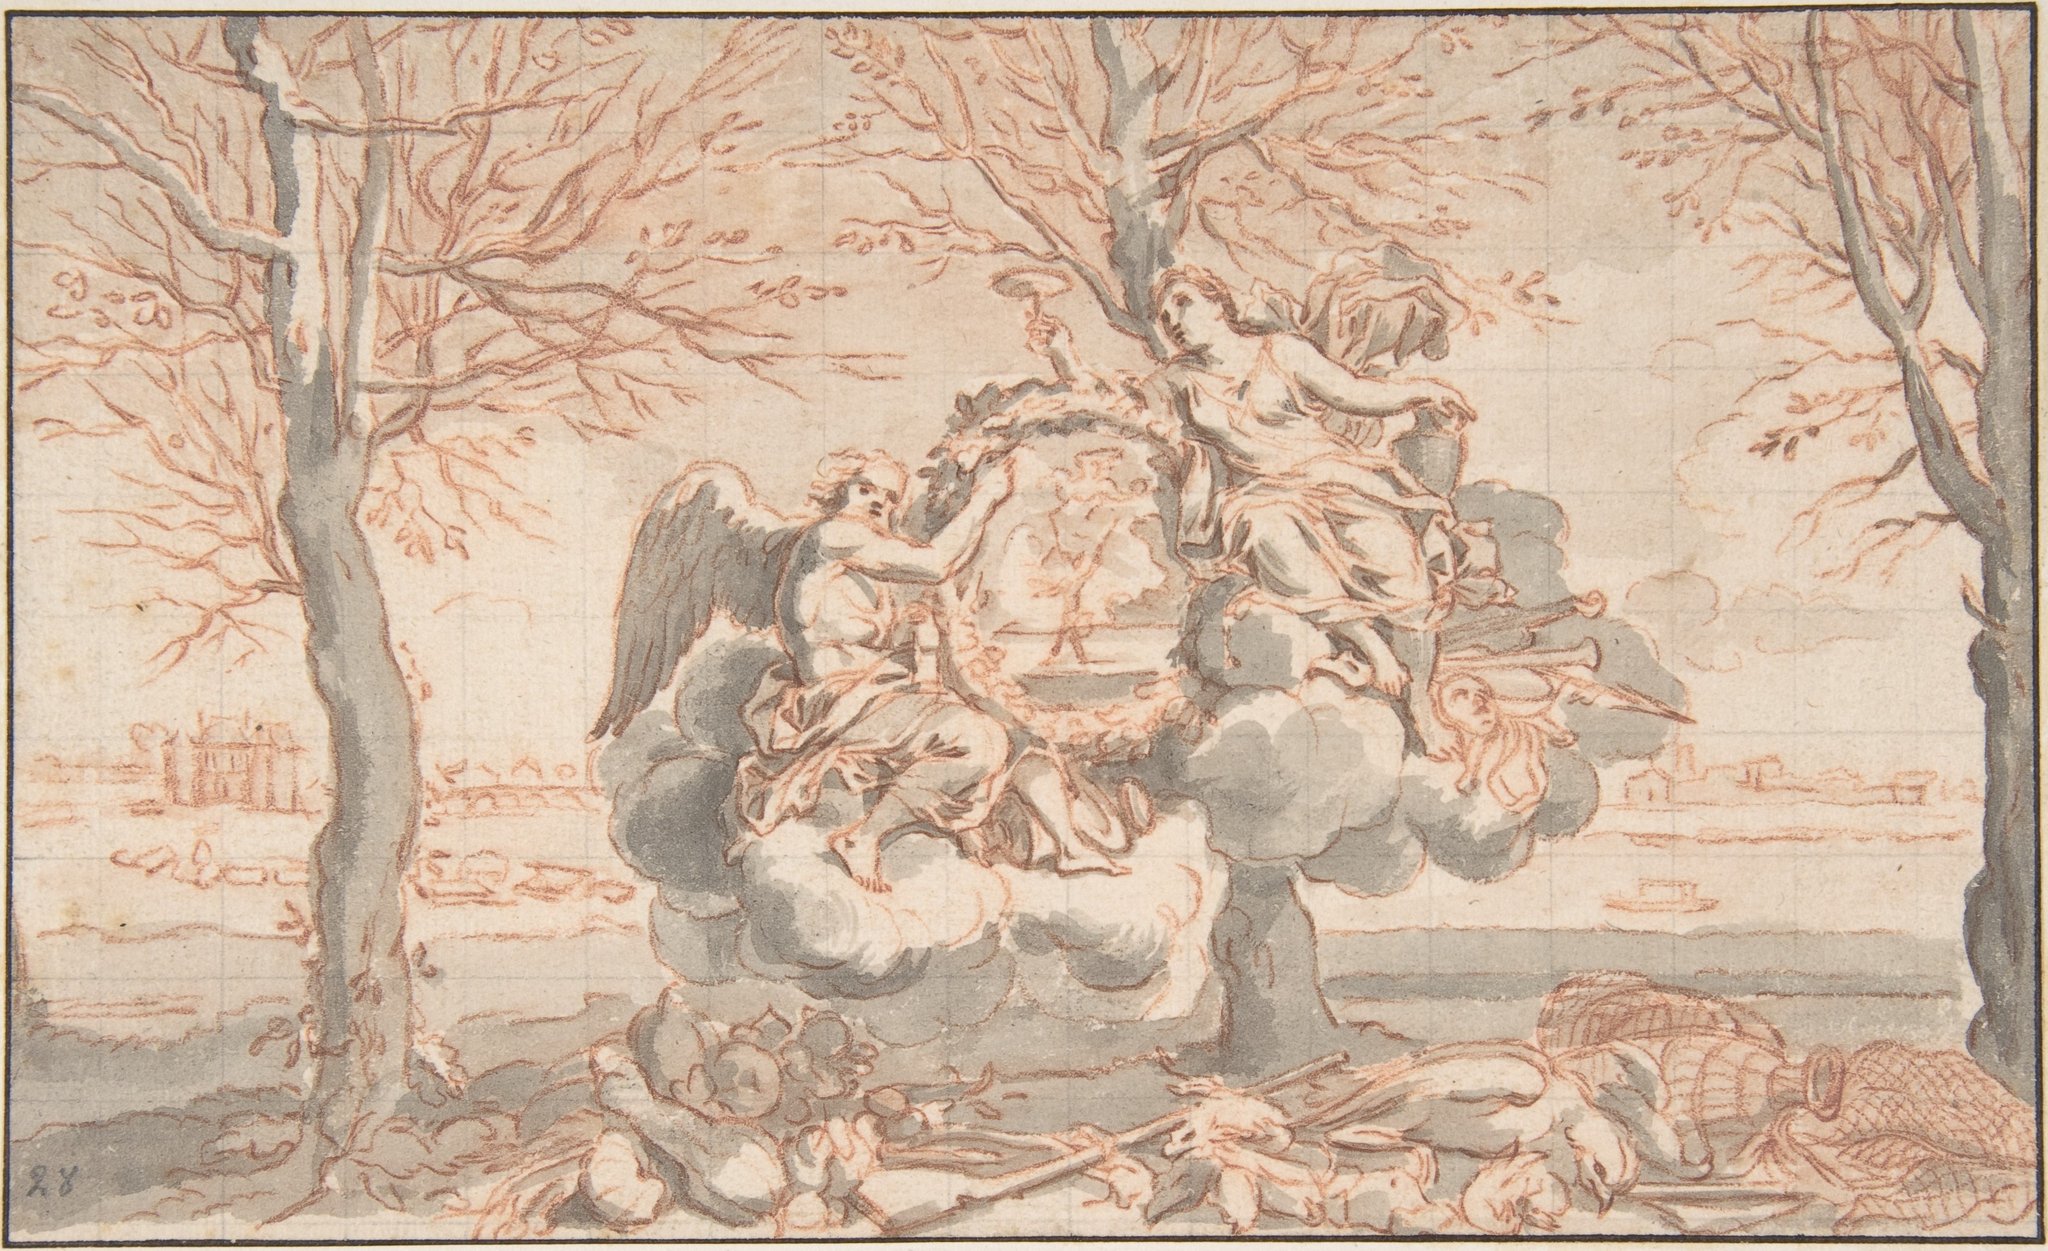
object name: drawing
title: Allegory of Winter, after Sébastien Le Clerc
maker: anonymous, french, 18th century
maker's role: artist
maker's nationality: french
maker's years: 1700-1800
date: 1701-1800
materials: chalk, graphite, ink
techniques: brush, pen, drawing, wash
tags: landscapes,winter